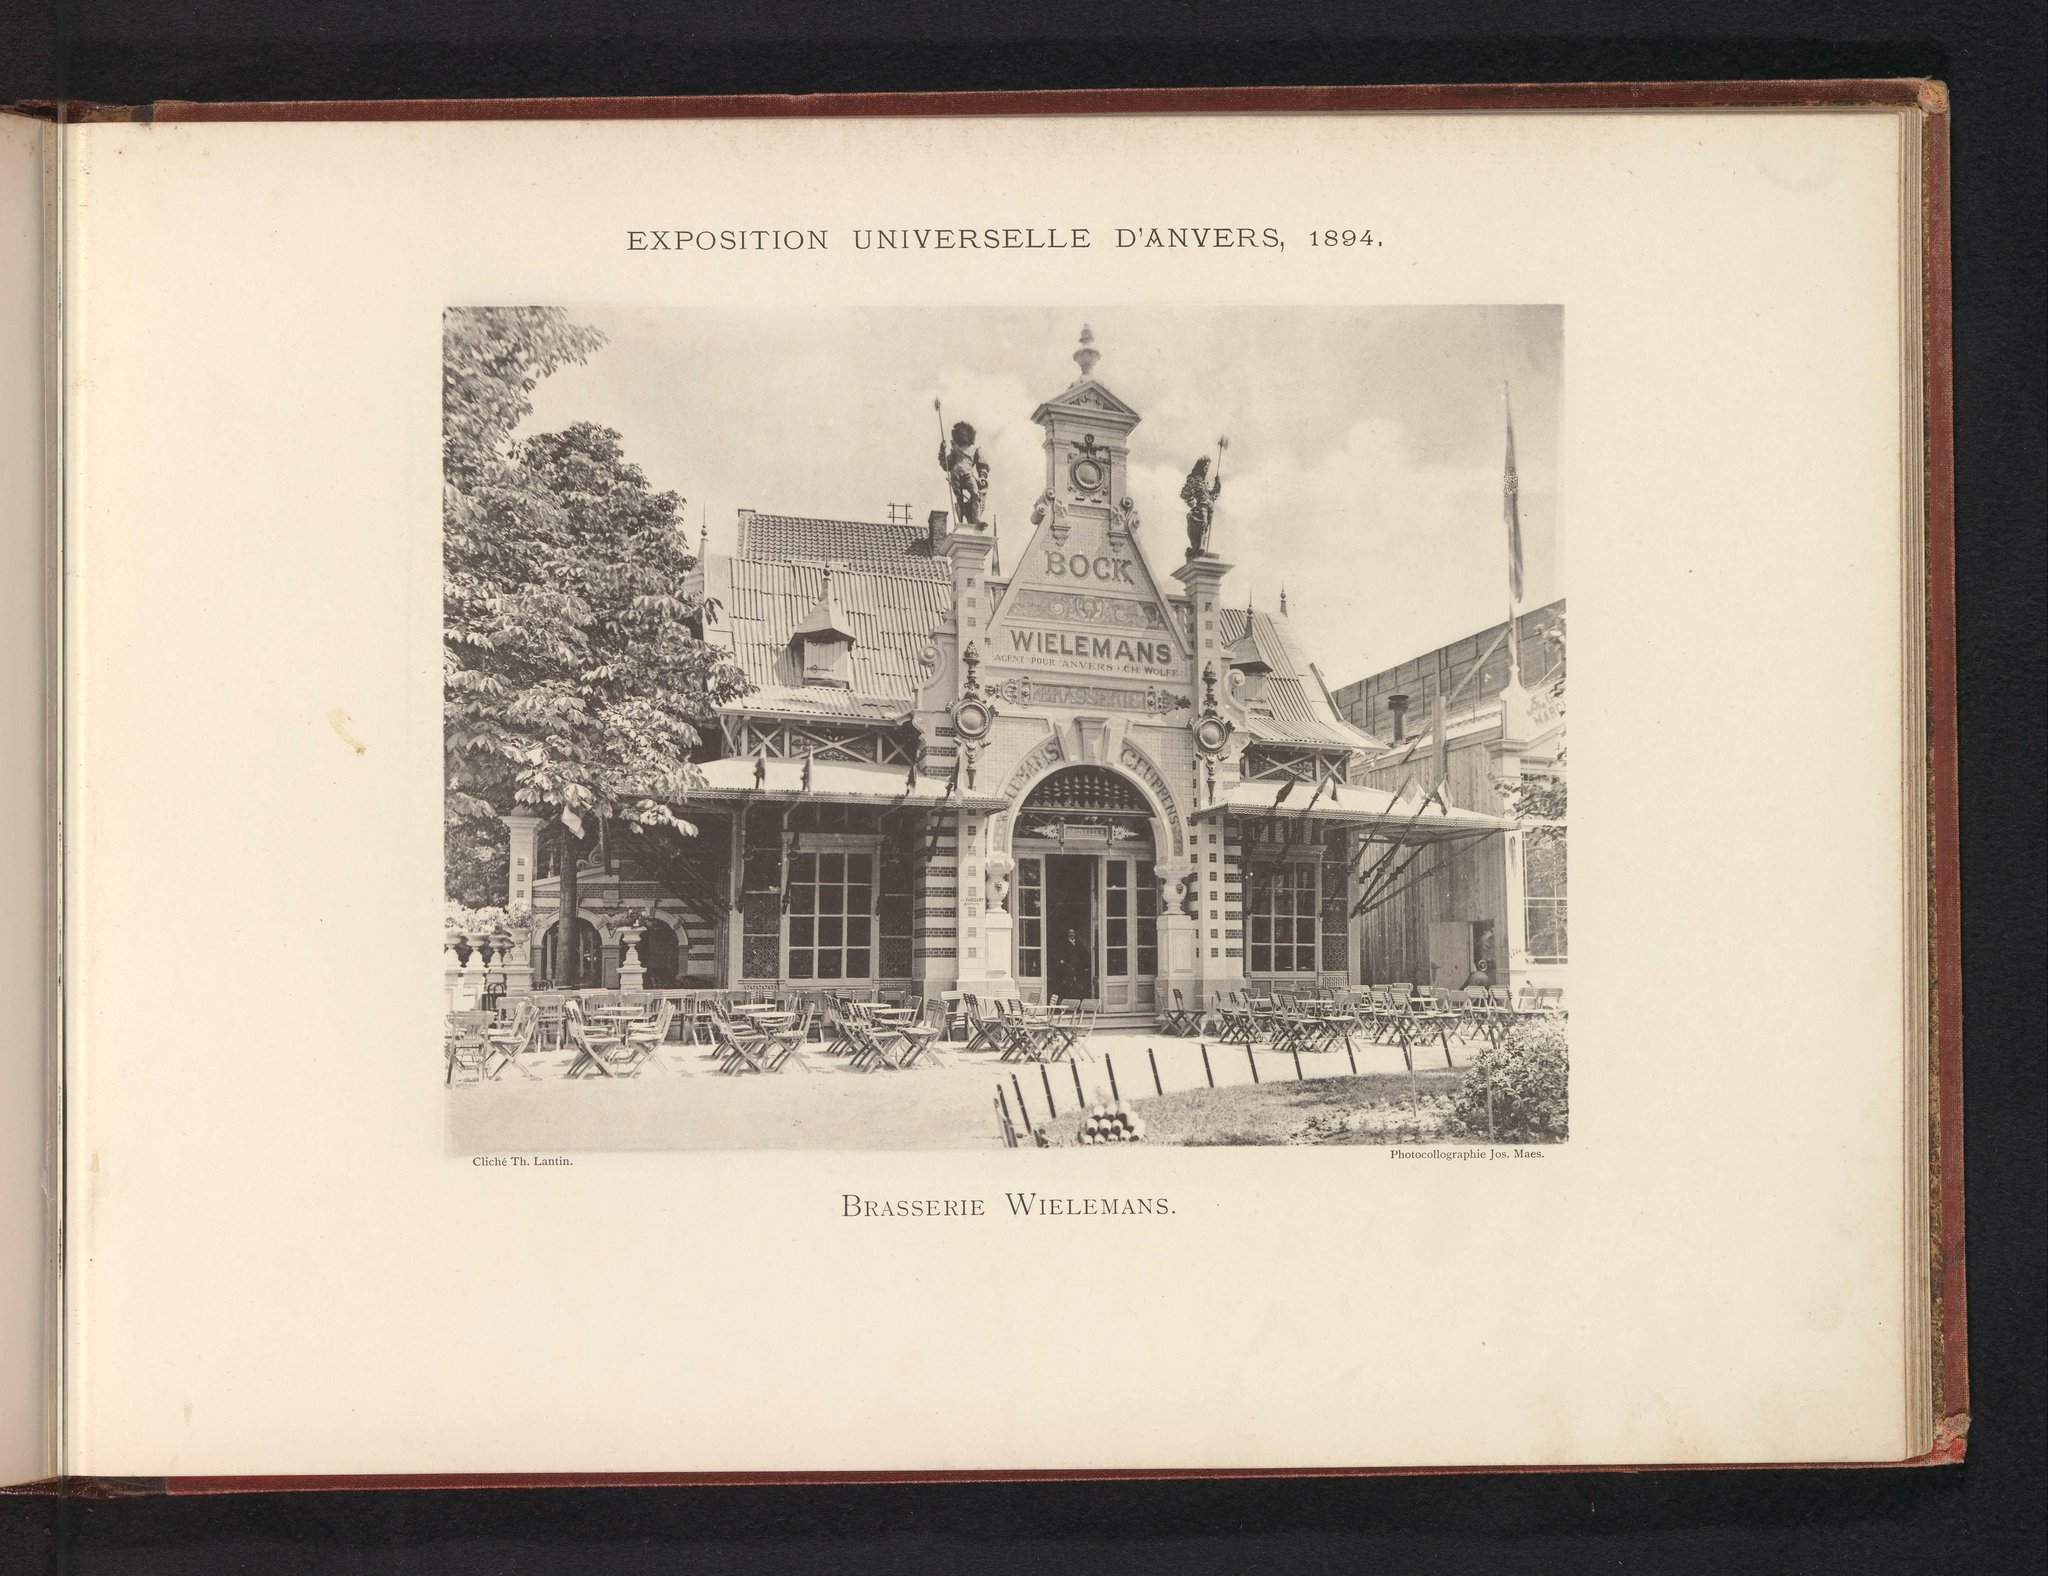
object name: page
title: Brasserie Wielemans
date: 1890-1894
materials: paper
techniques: photograph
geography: antwerp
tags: façade (of house or building), restaurant